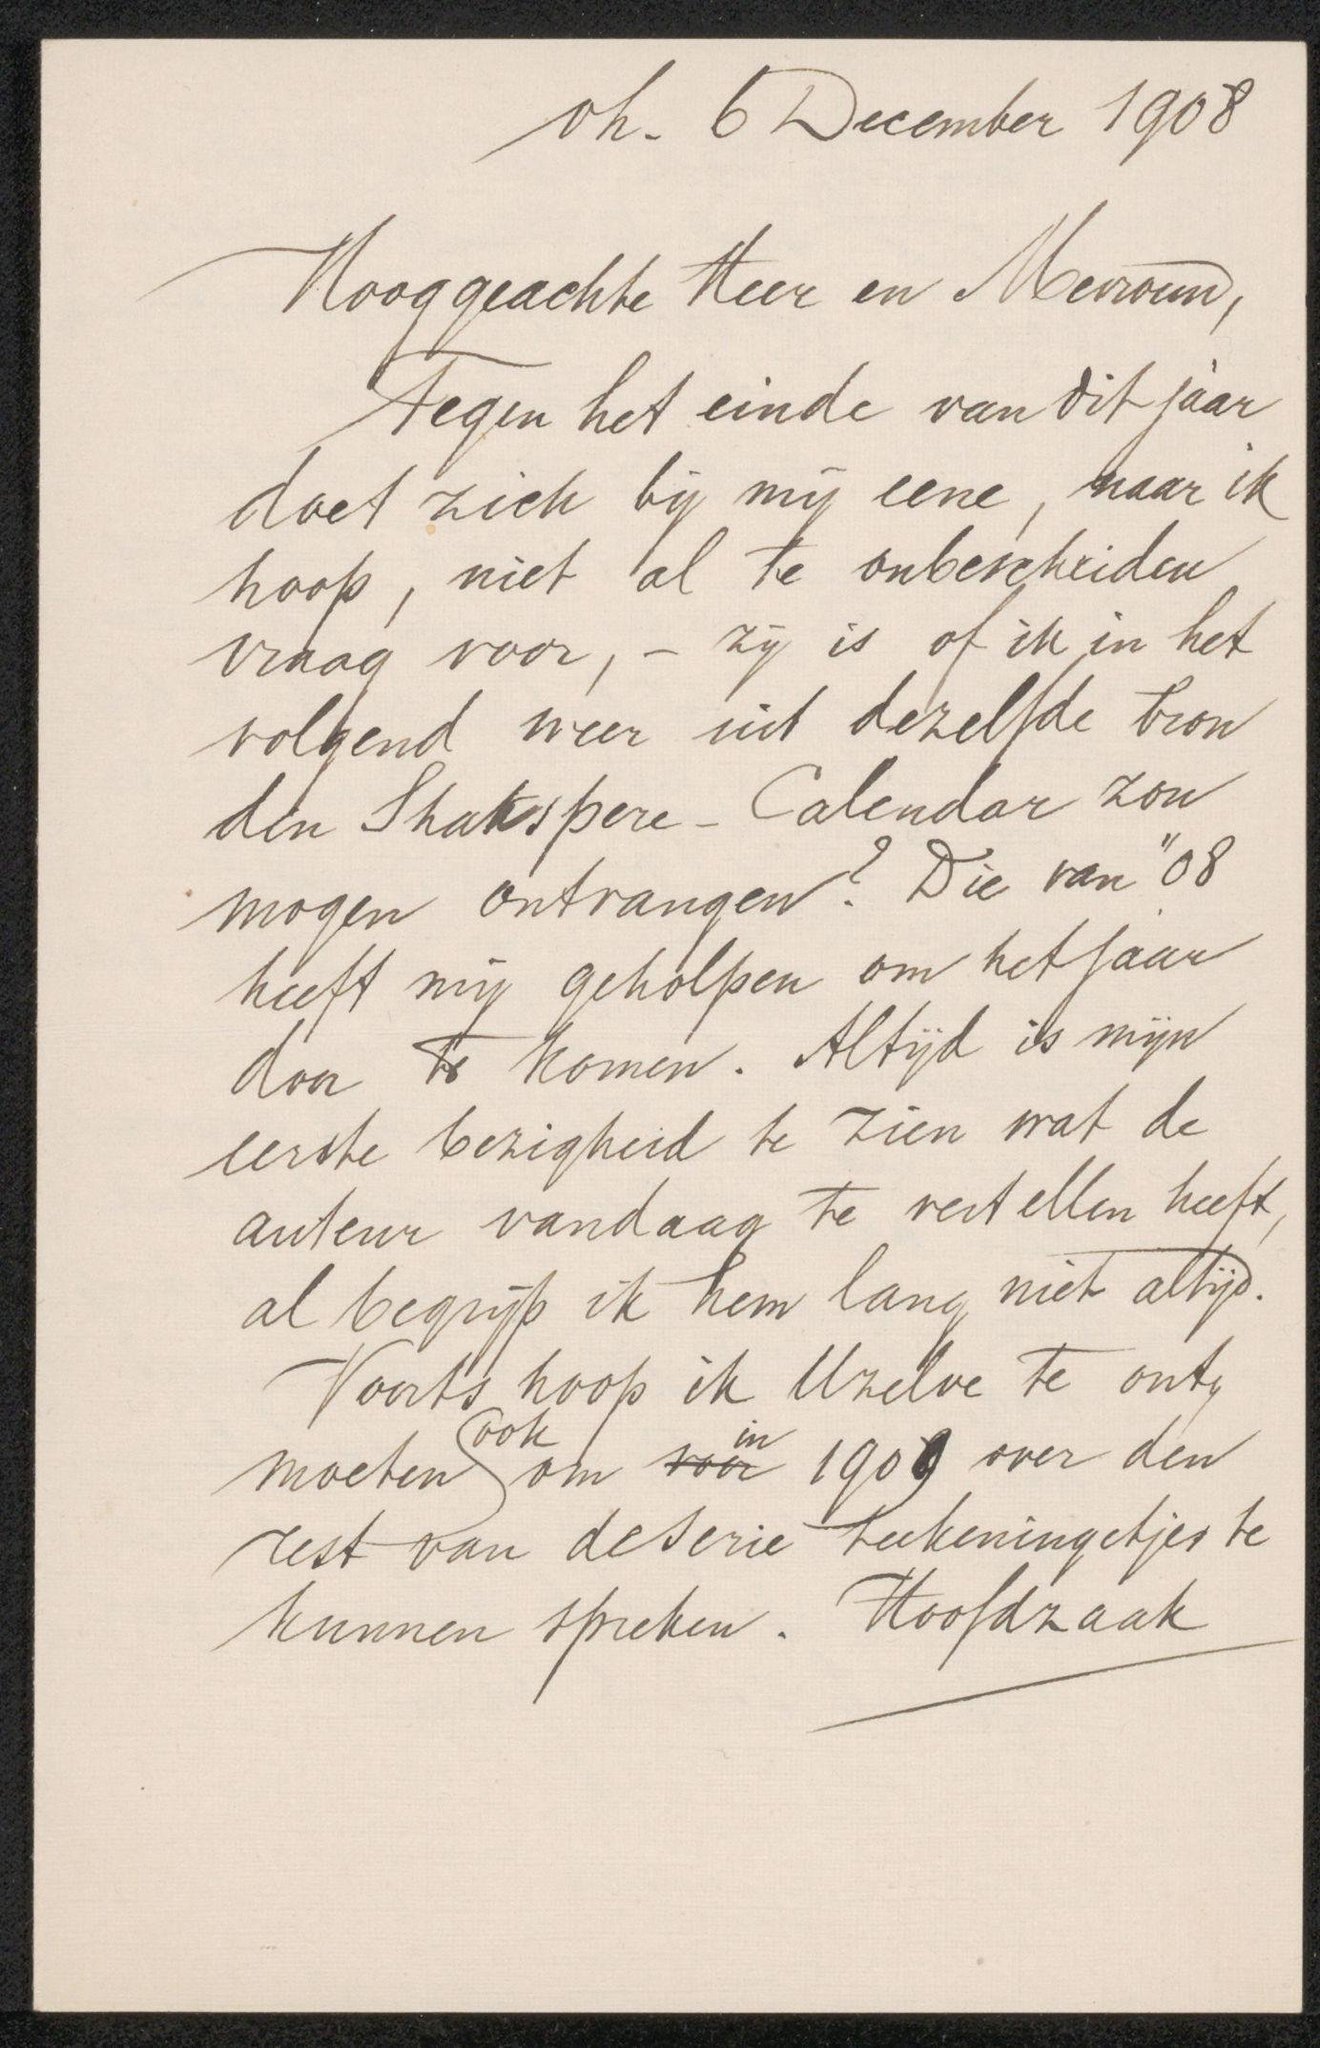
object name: letter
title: Brief aan Max Wilhelm Carl Weber en Anne Antoinette Weber-Van Bosse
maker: august allebé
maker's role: draughtsman, print maker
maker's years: 1838-1927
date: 1908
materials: ink, paper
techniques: pen, writing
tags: rotterdam, charles albert de burlet, amsterdam, anne antoinette weber-van bosse, drawing, diseases